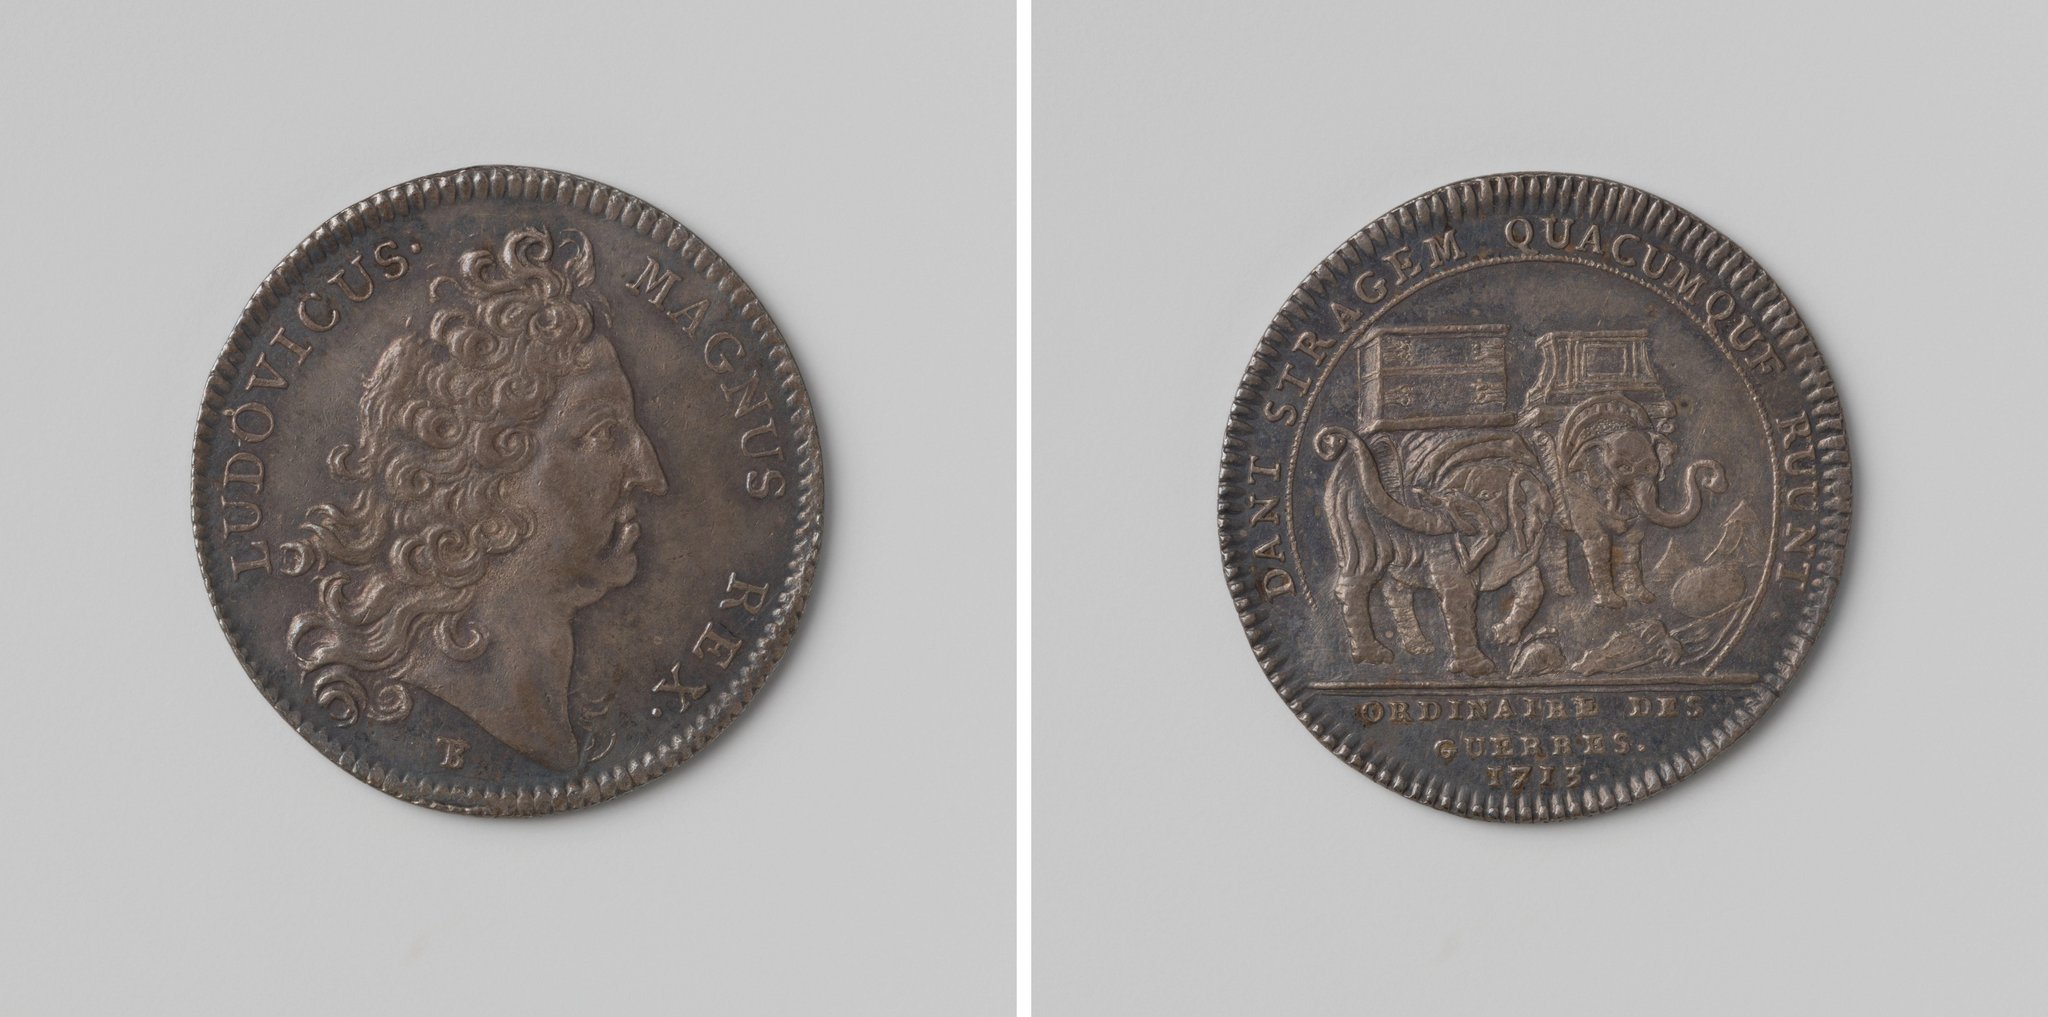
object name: jeton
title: Verovering van Douai, Quesnoy en Bouchain, rekenpenning geslagen ter ere van Lodewijk XIV, koning van Frankrijk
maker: thomas bernard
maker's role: artist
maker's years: 1650-1713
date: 1713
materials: silver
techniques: striking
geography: paris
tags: lodewijk xiv (koning van frankrijk)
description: Zilveren penning. Voorzijde: borststuk man binnen omschrift. Keerzijde: twee krijgsolifanten met torens op rug, die wapentuig vetrappen binnen omschrift; afsnede: opschrift.